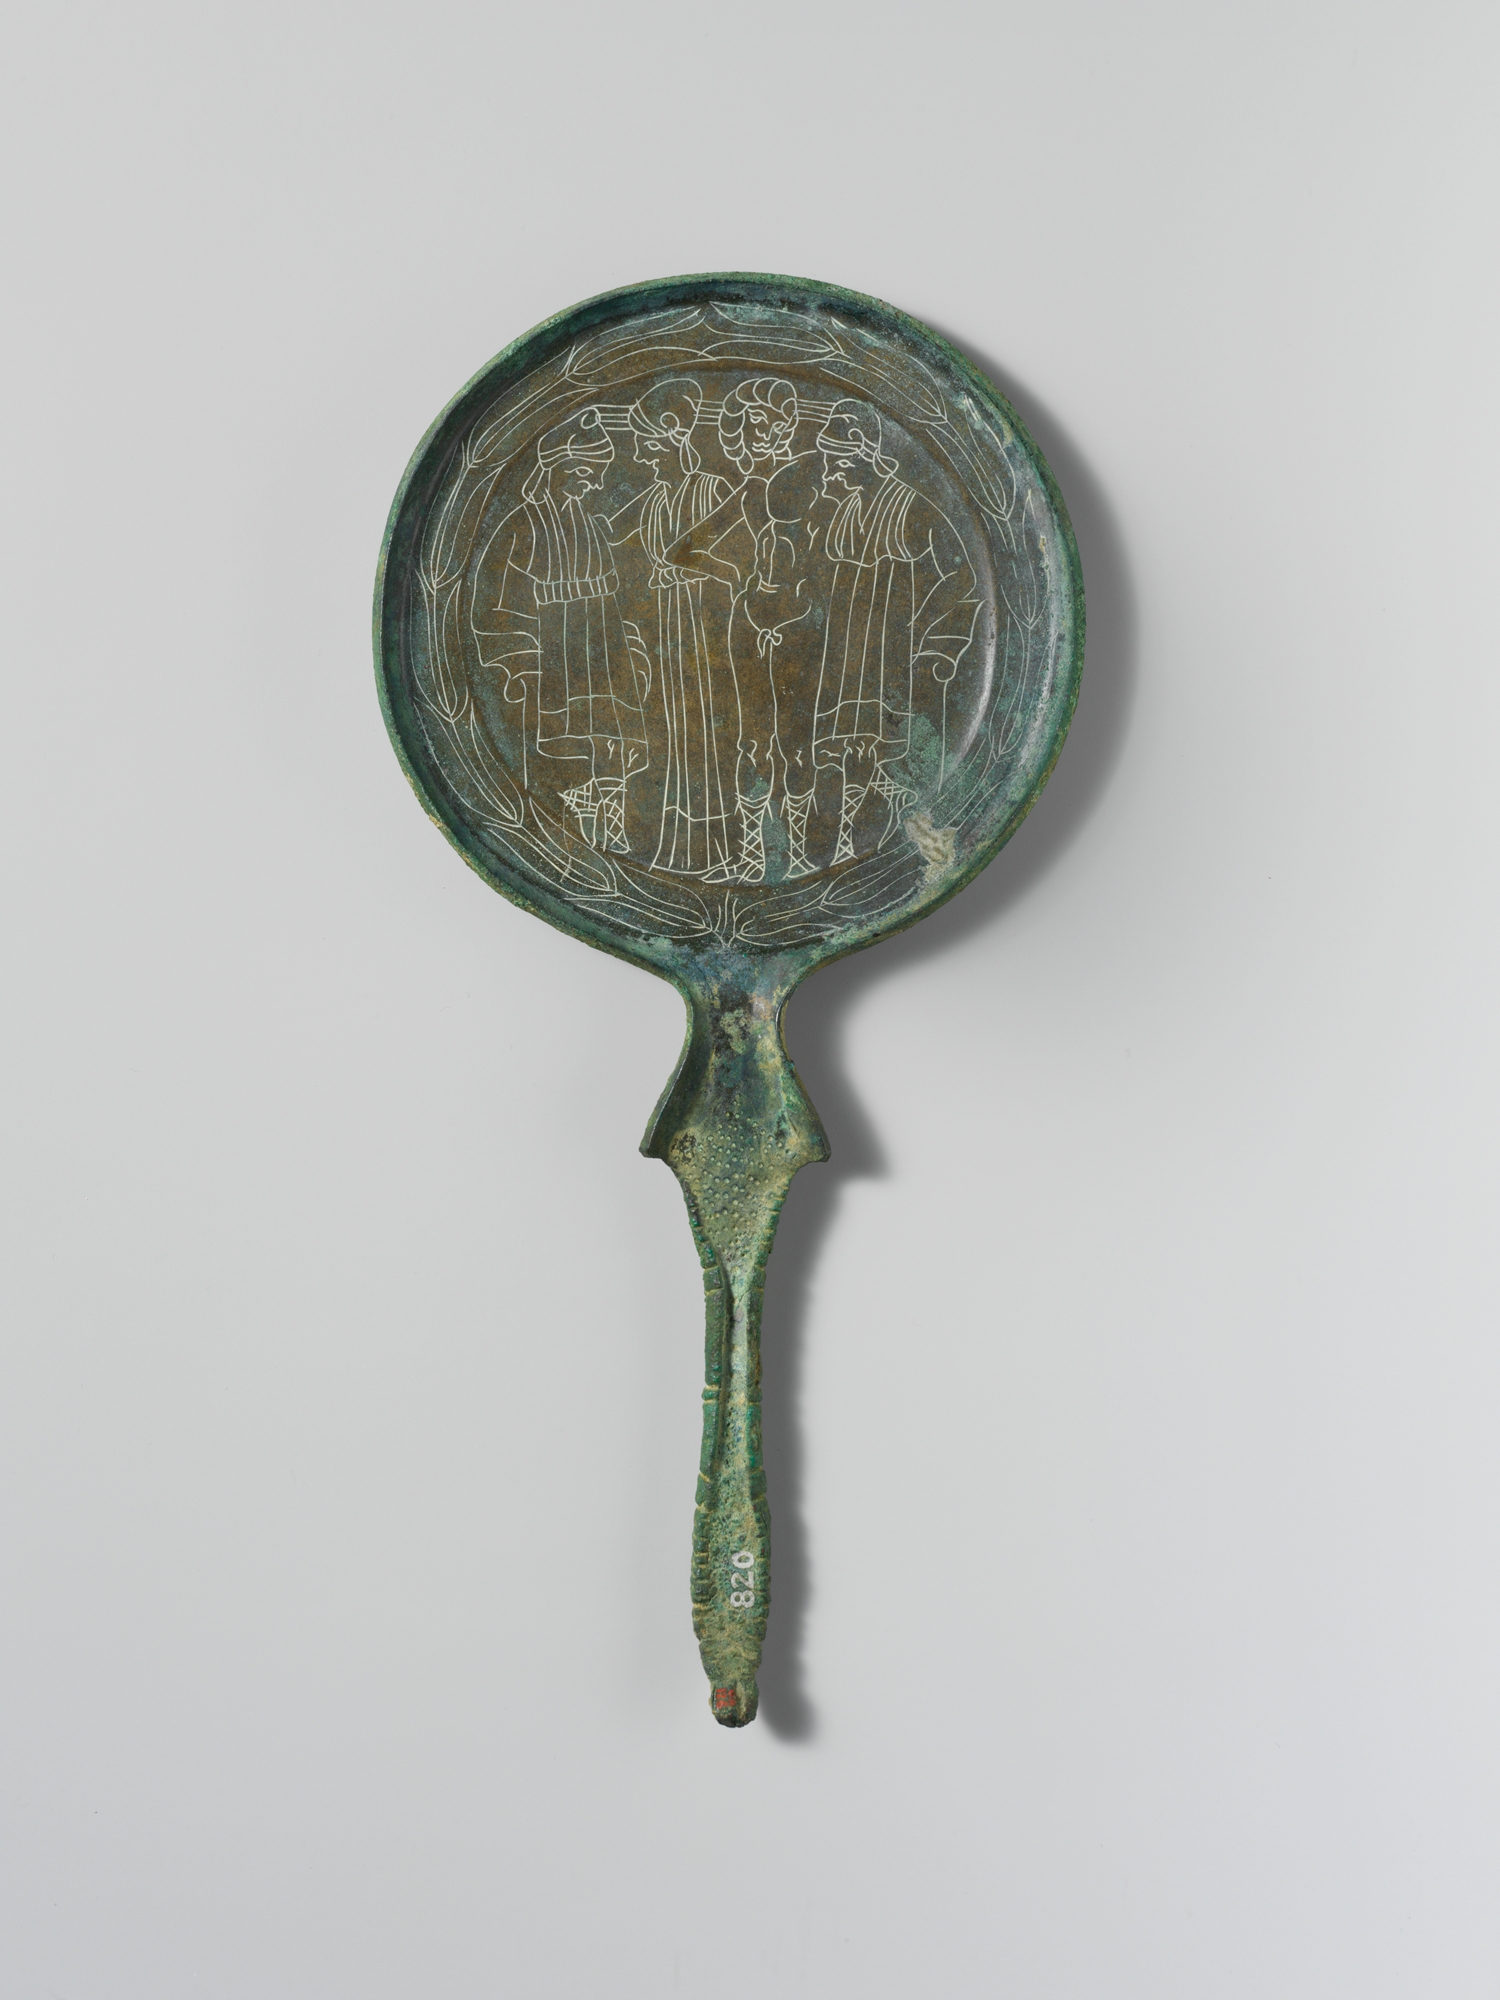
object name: mirror with dioskouroi, minerva, and youth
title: Bronze mirror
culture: etruscan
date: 300-101 BCE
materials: bronze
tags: male nudes,women